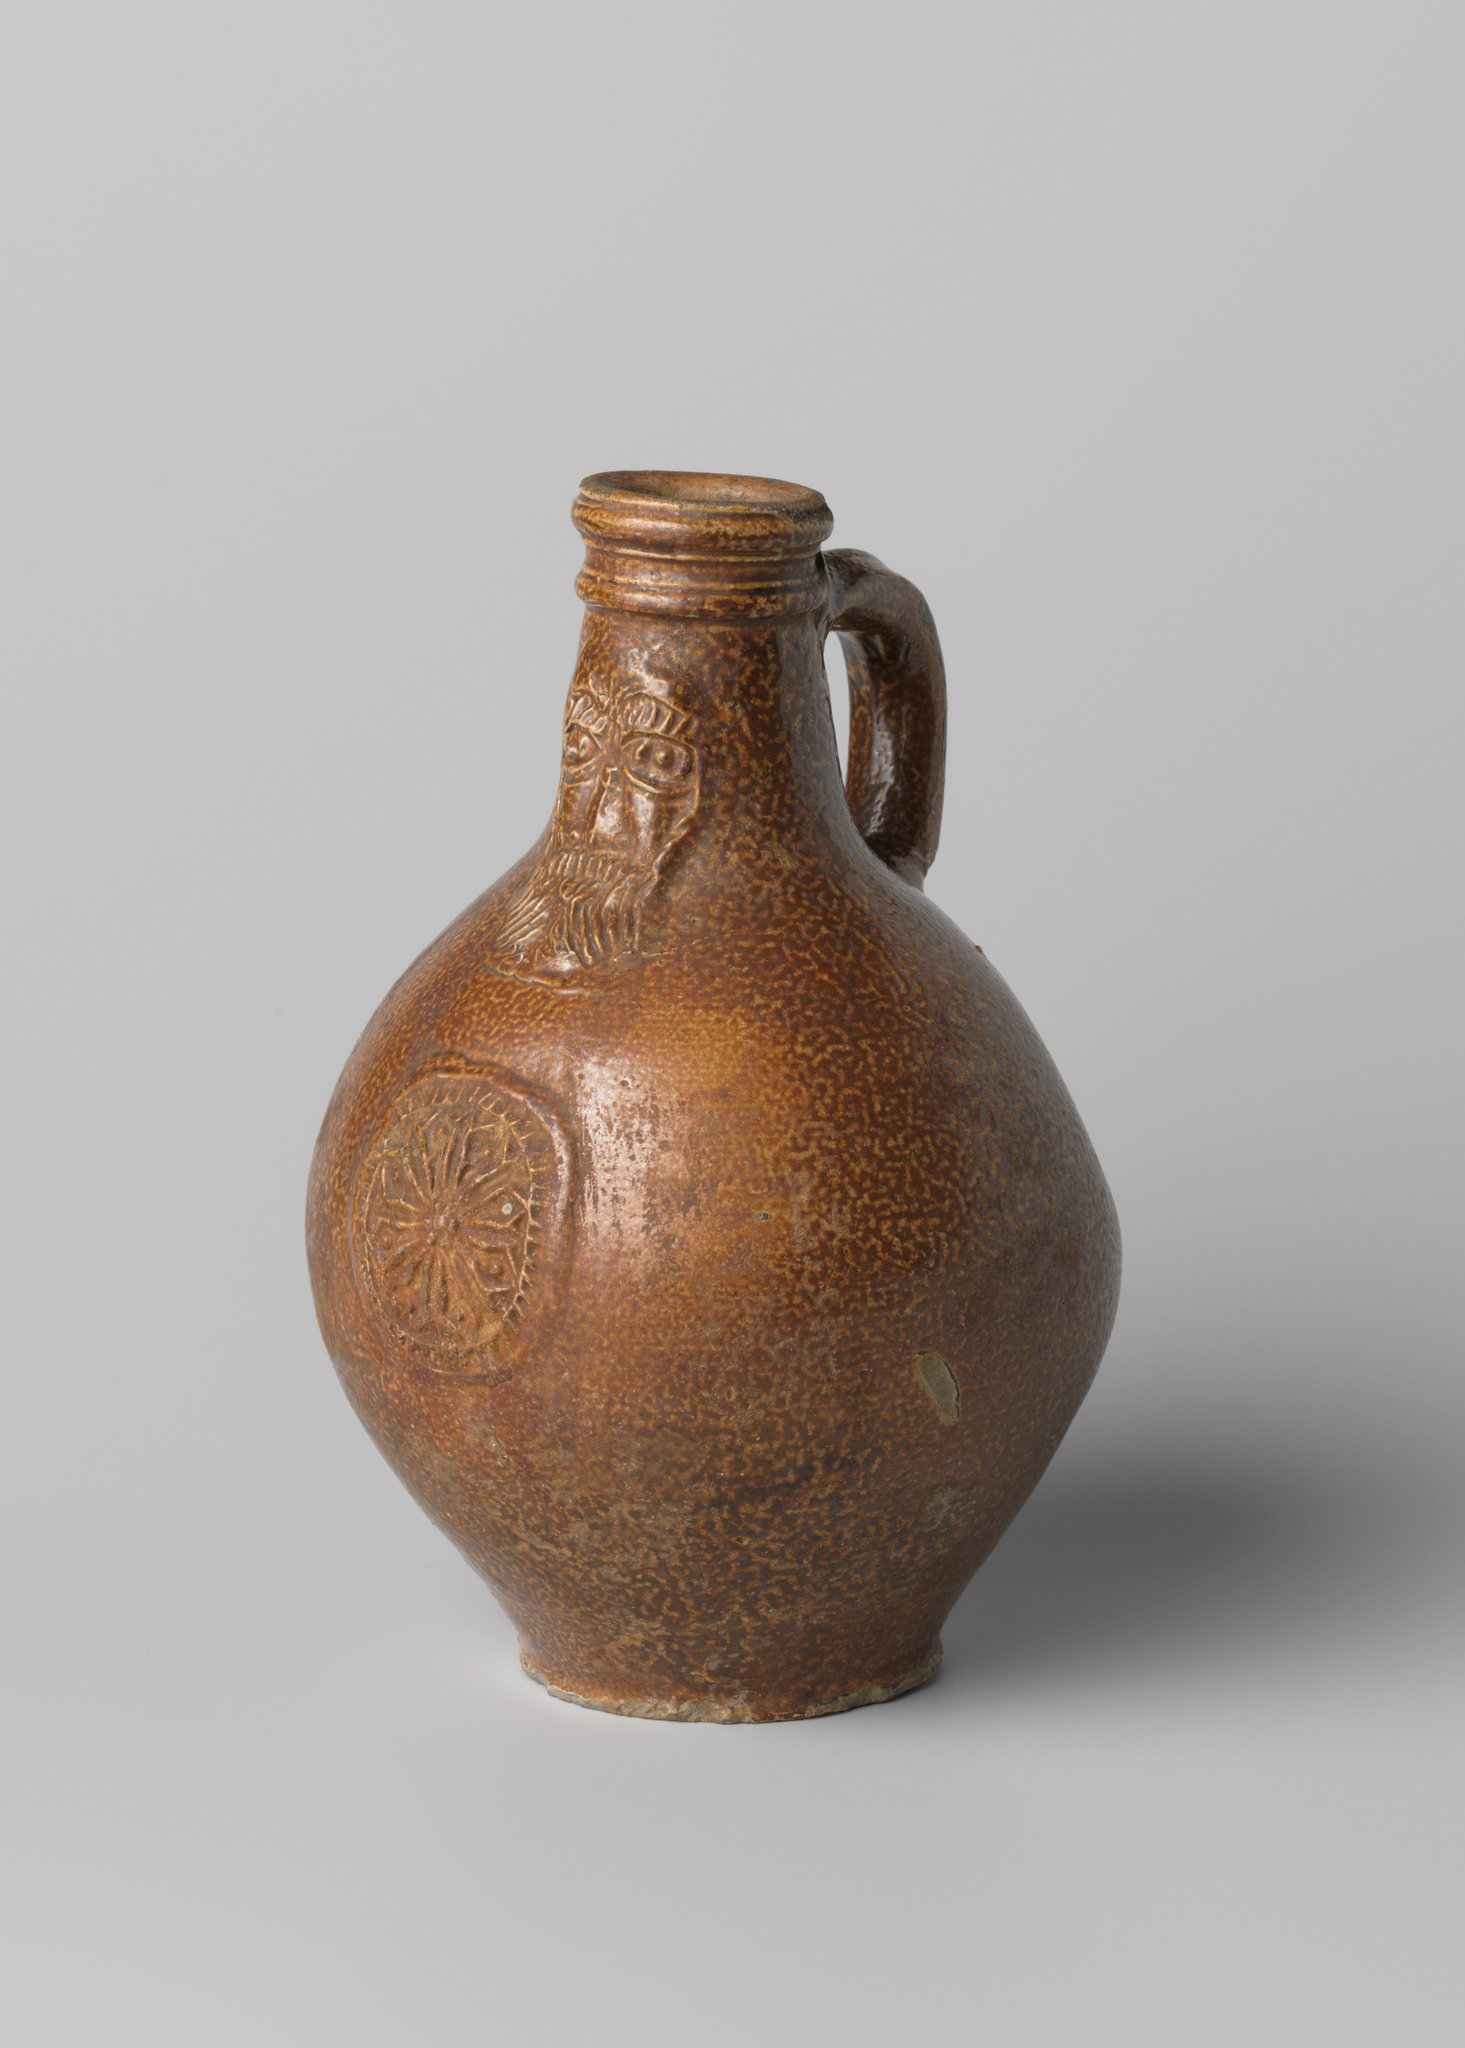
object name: jug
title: Jug (Bartmann jug) with a roundel in a medallion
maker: Anonymous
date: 1650-1749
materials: engobe, glaze, stoneware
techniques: firing, forming, relief, turning, vitrification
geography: frechen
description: Kruik (baardmankruik) van steengoed op standvlak met een bolvormige buik en smalle nek. Het C-vormige oor is bevestigd aan de nek en de schouder. Profielen op de nek. Bedekt met een bruine engobe. In reliëf op de buik een gedrukt en opgelegd medaillon met een rozet. Op de nek, doorlopend op de schouder, een baardman. Frechen.